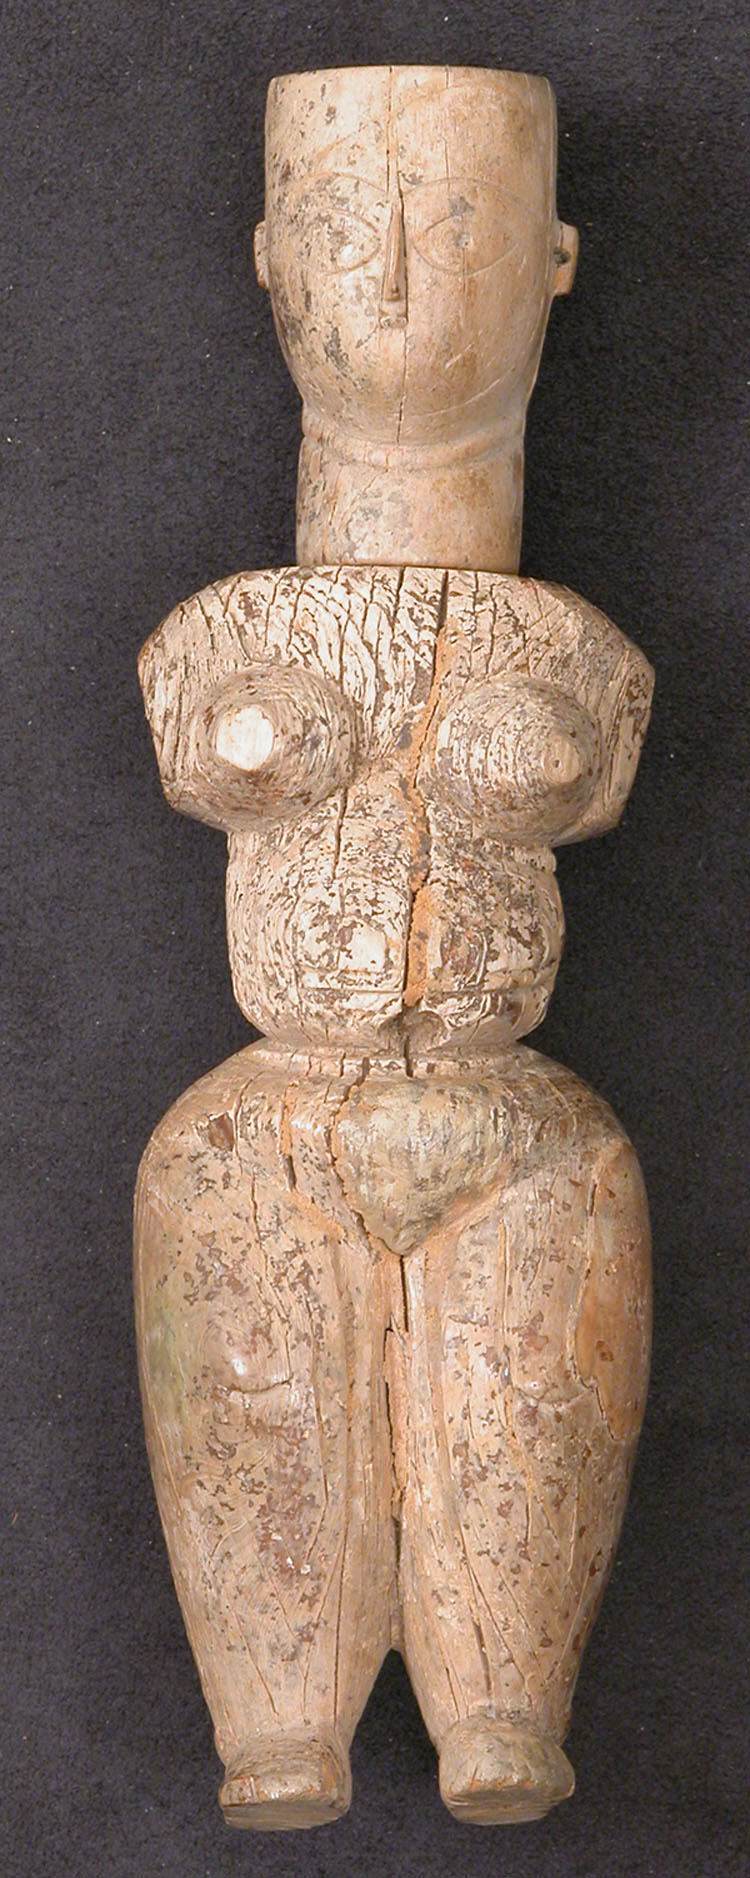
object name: figure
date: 901-1200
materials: ivory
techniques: carving, incising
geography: iran